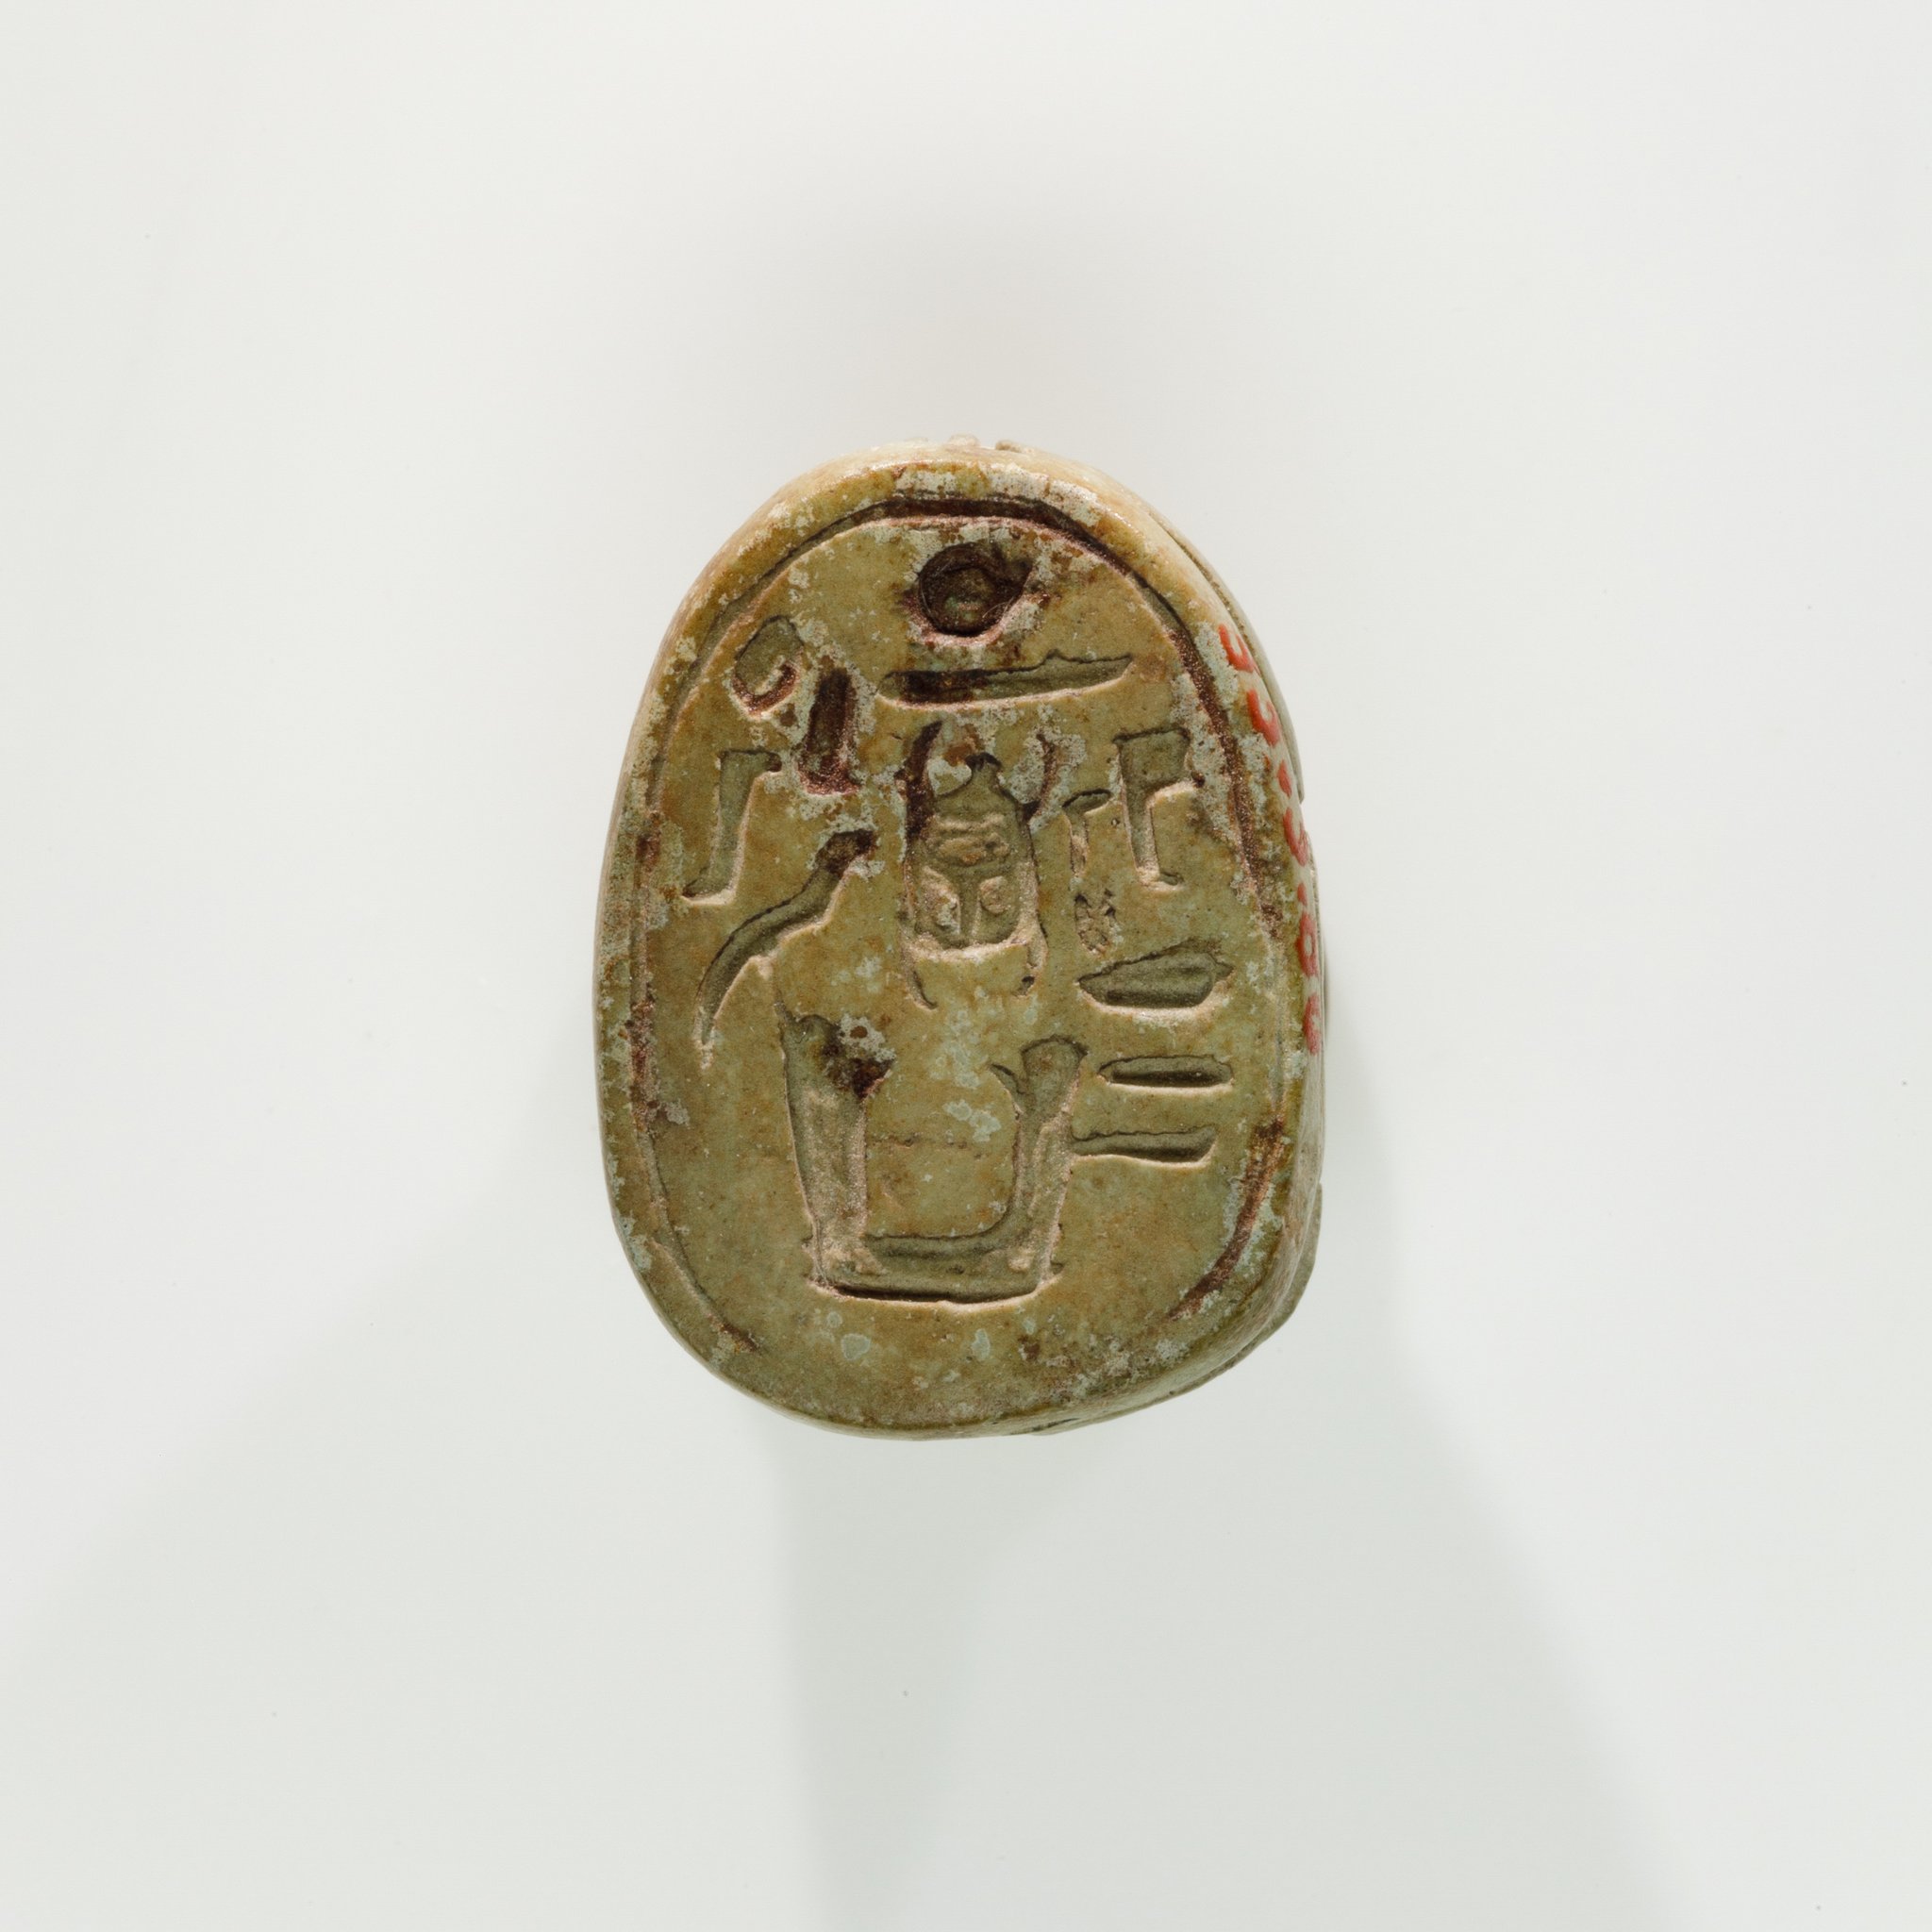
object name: scarab, thutmose i, rennefer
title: Scarab with the Throne Name of Thutmose I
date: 1504-1447 BCE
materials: faience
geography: egypt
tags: scarabs